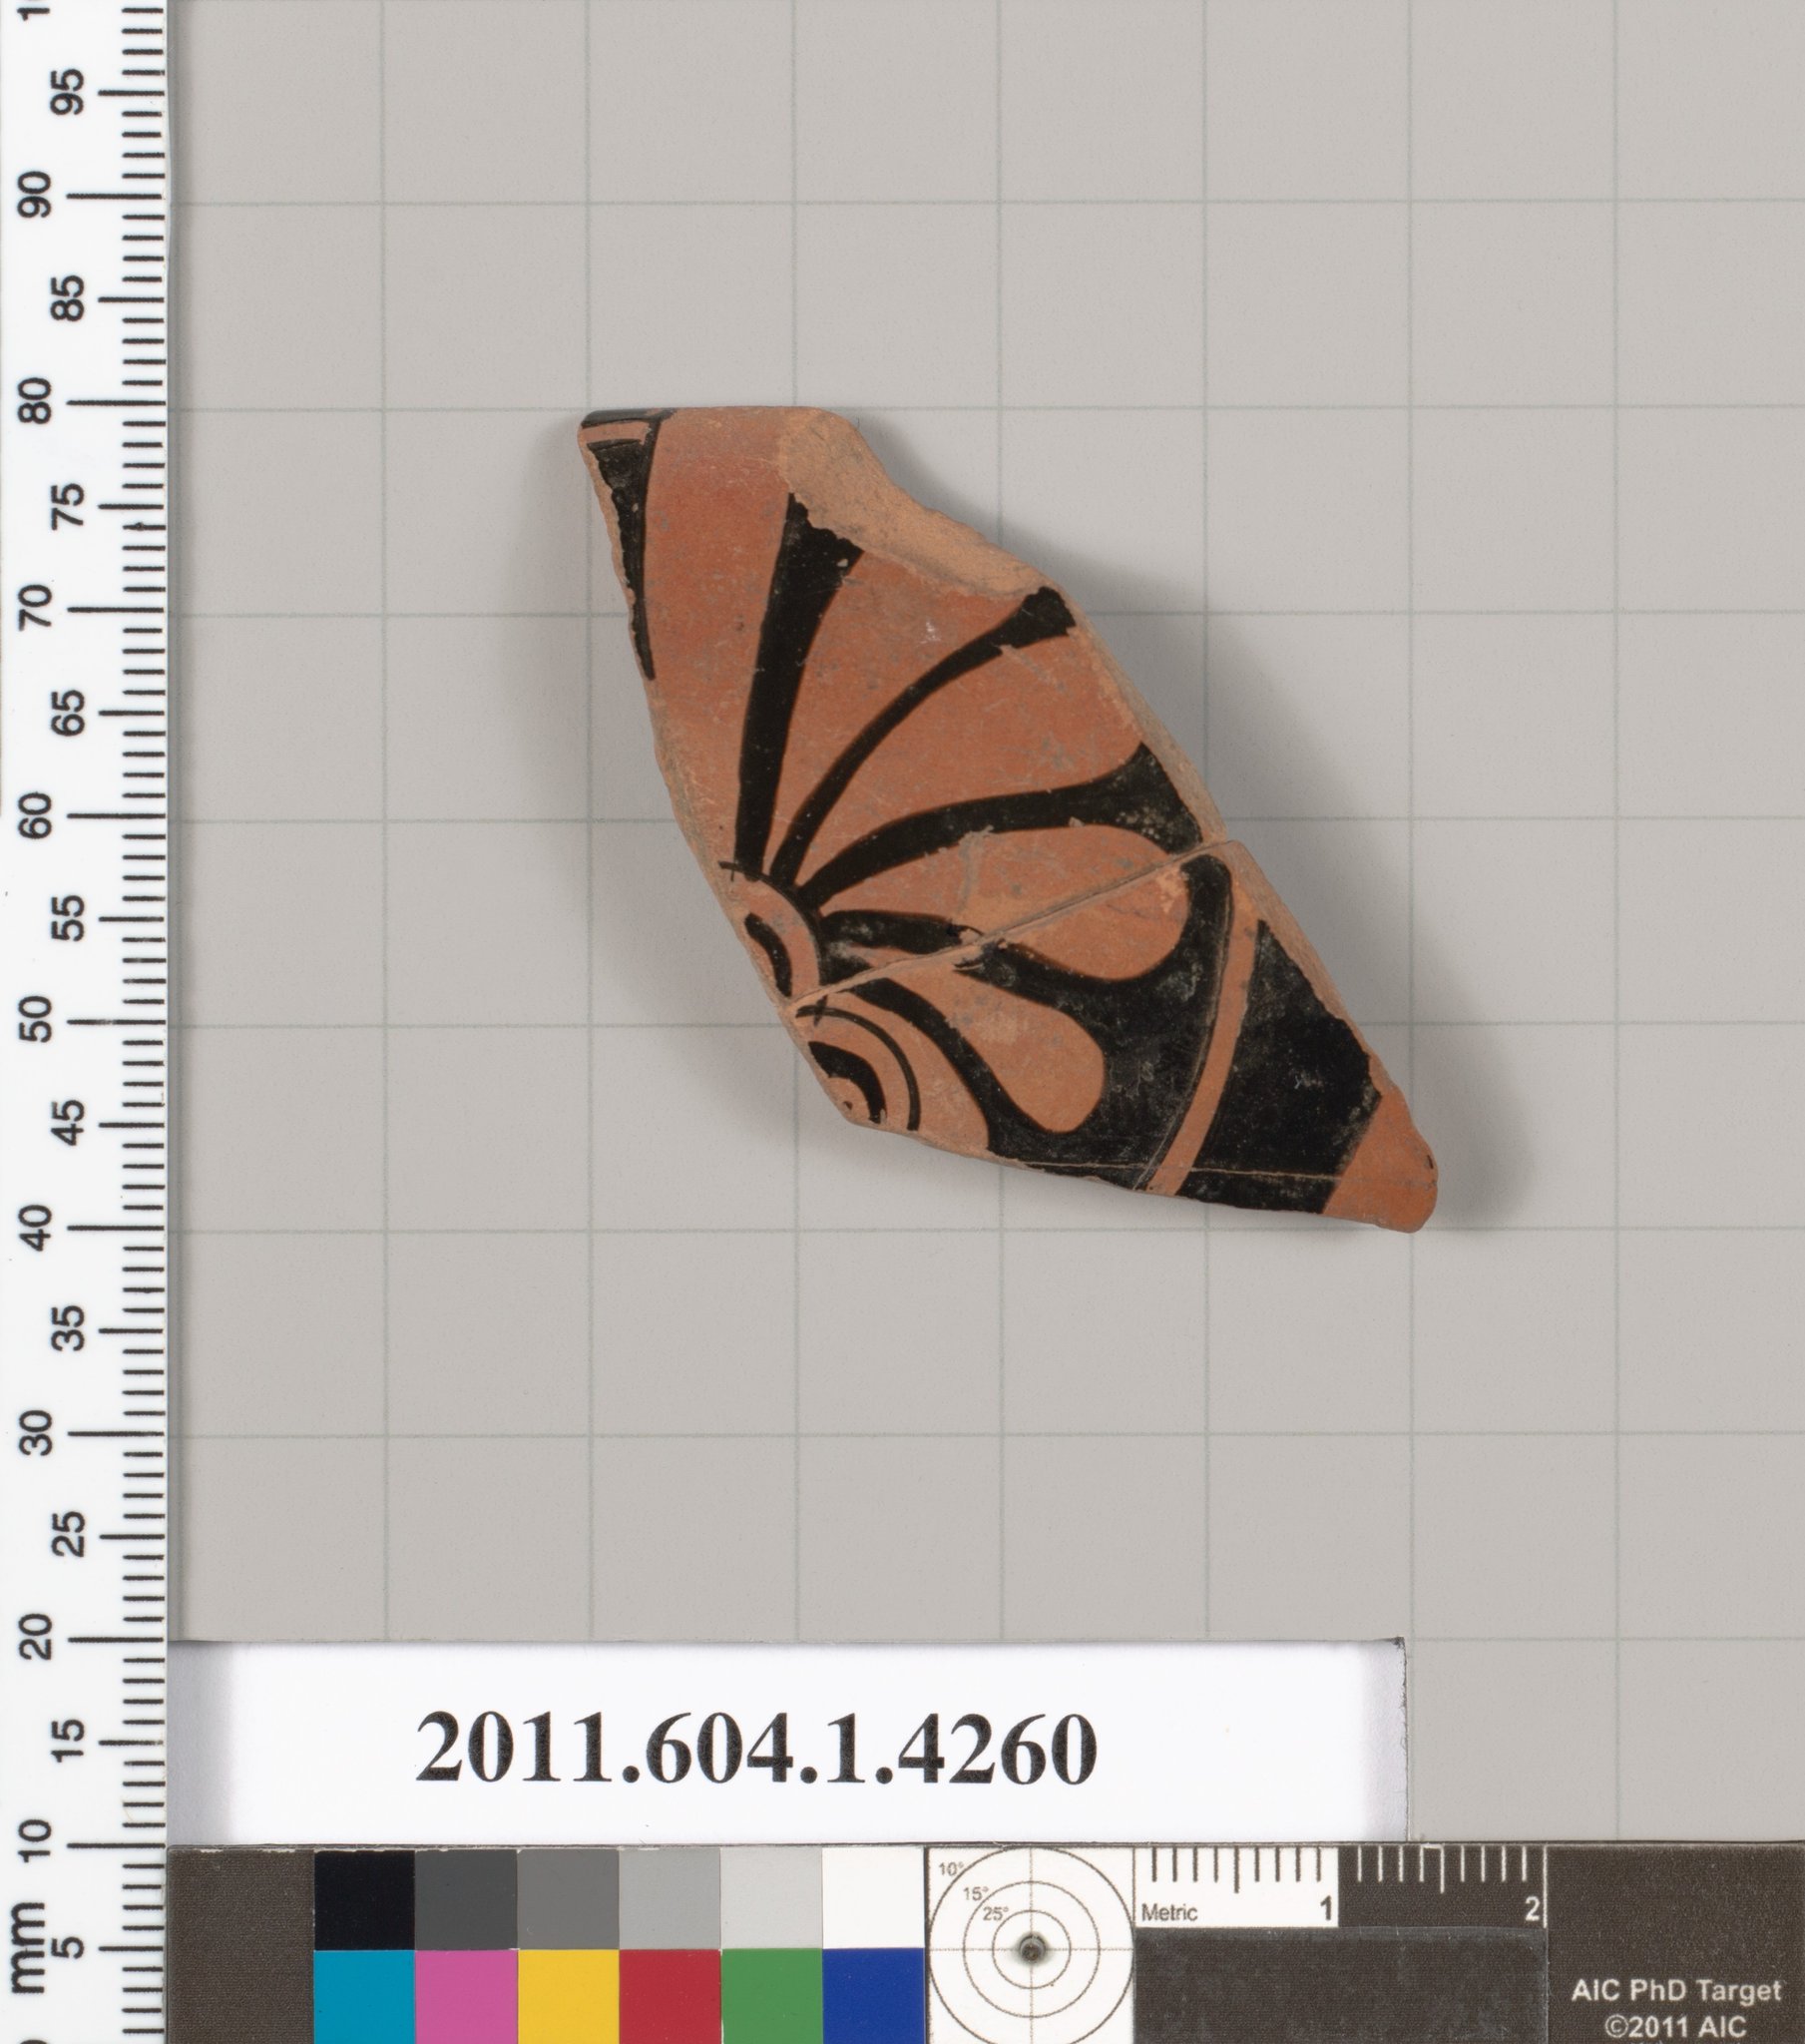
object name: kylix fragment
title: Terracotta rim fragment of a kylix (drinking cup)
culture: greek, attic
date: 520-500 BCE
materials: terracotta